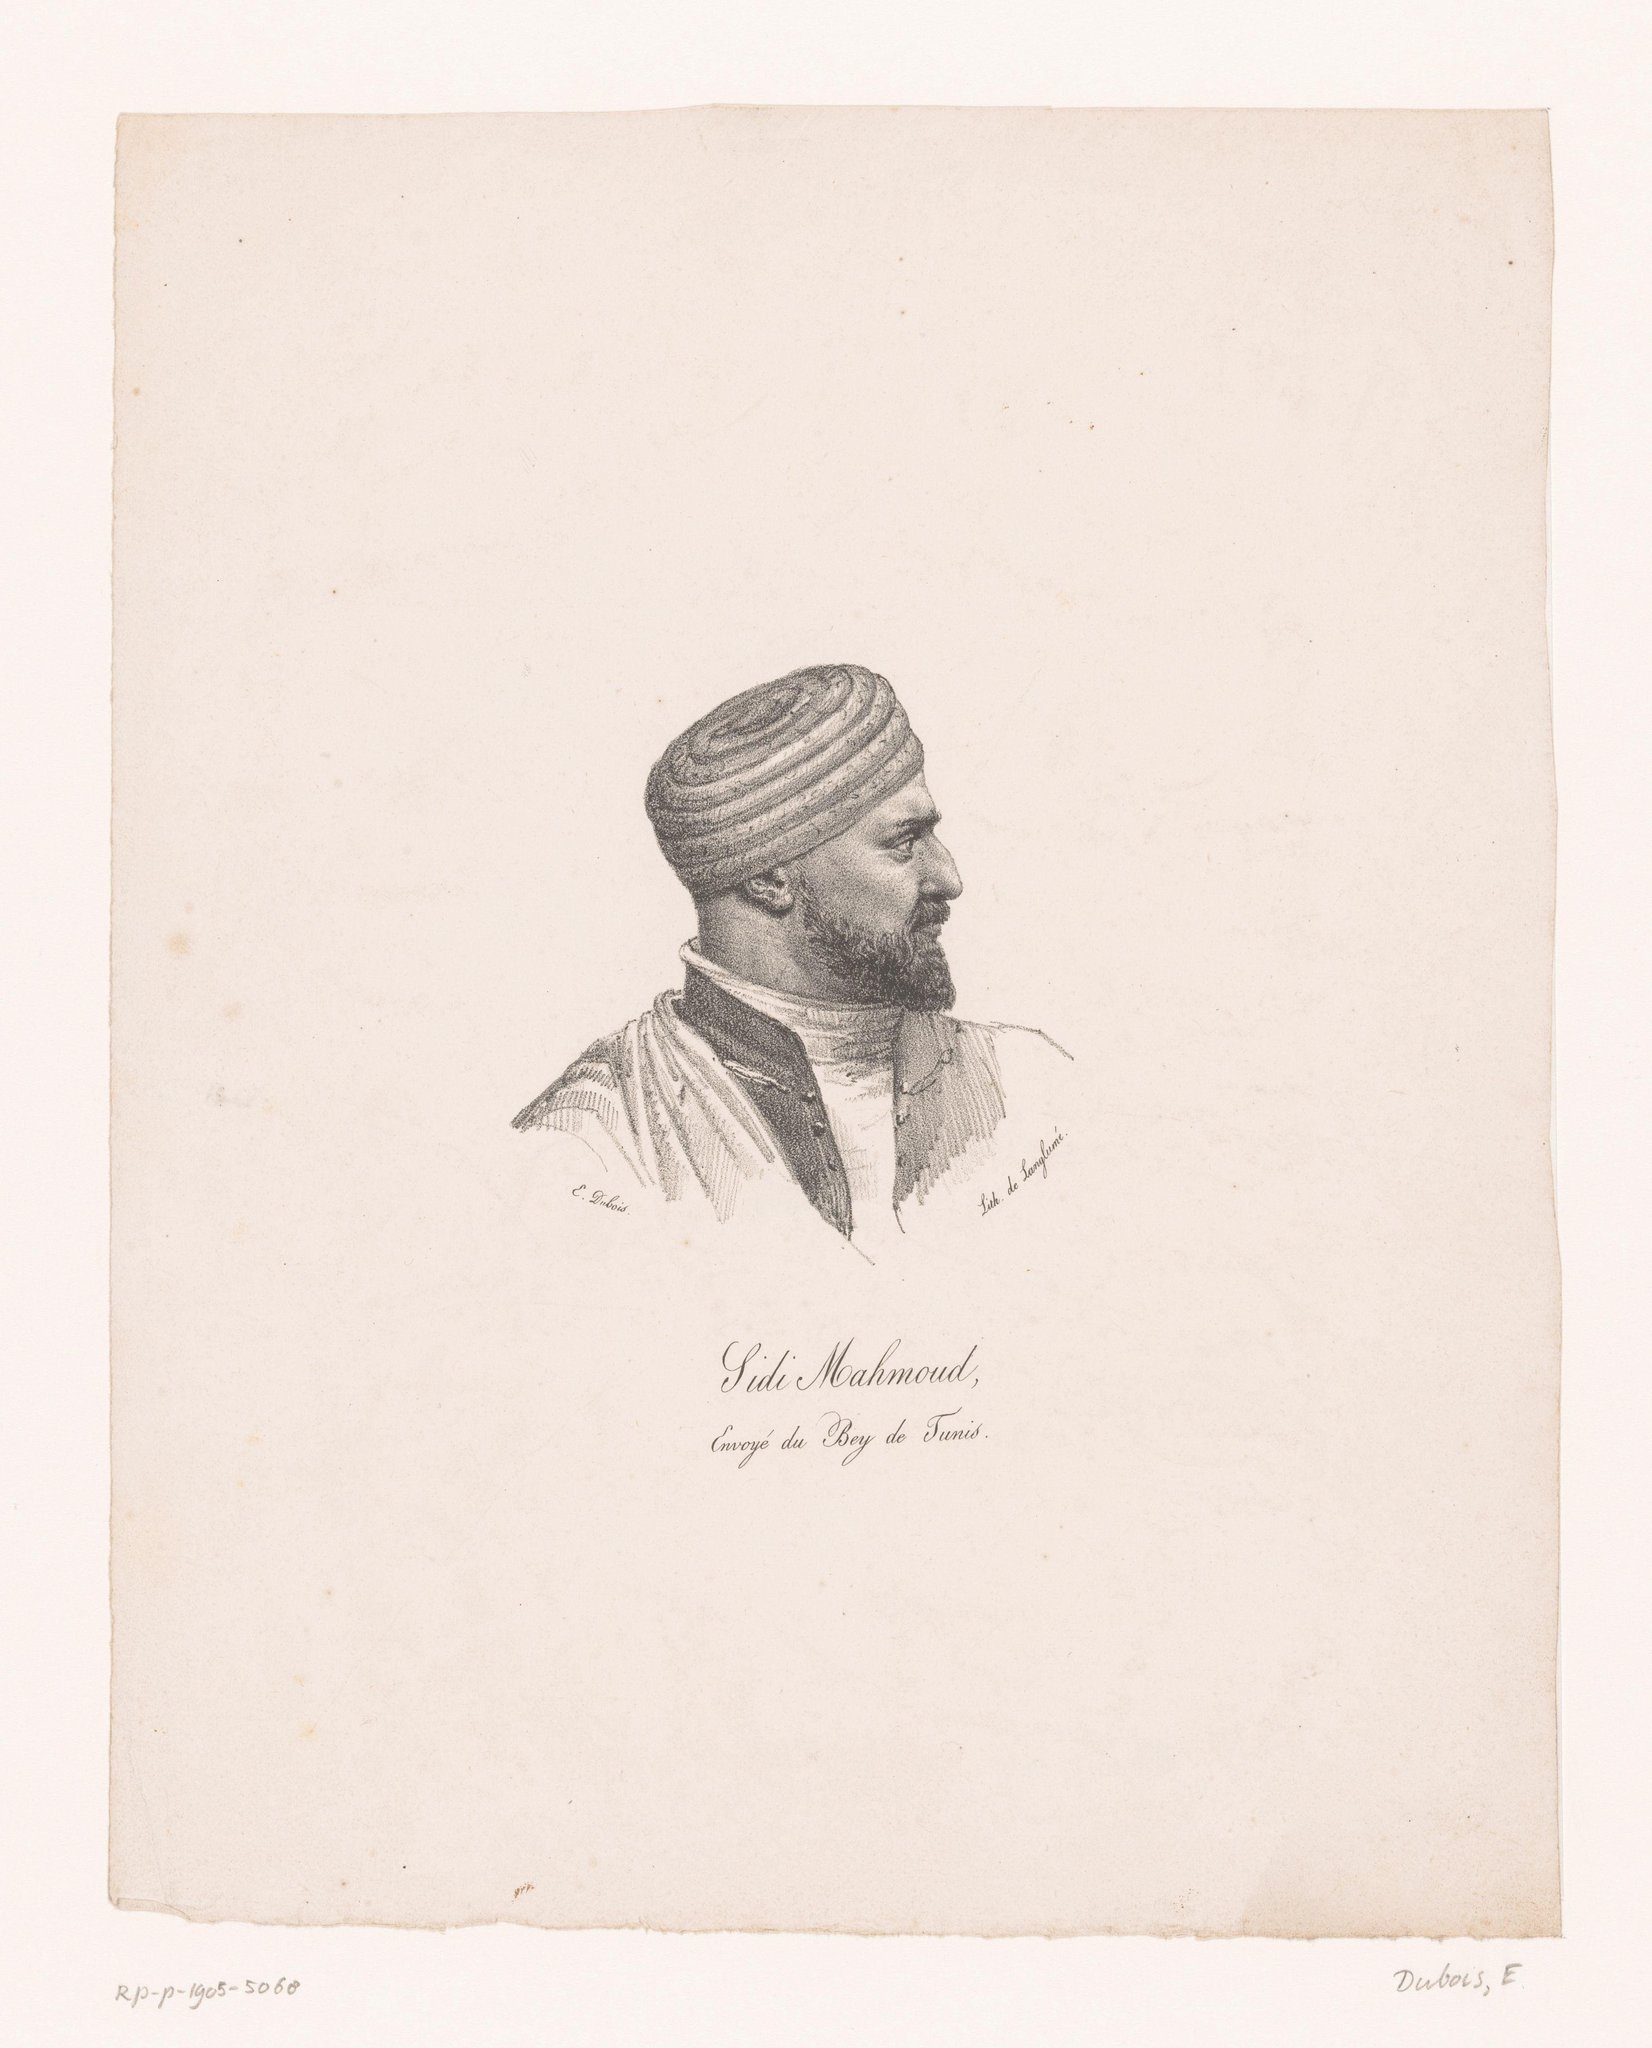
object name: print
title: Portret van de Tunesische ambassadeur Sidi Mahmoud Kahia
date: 1830-1831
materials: paper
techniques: lithograph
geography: paris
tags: historical persons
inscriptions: collector's mark: Lugt 2228a